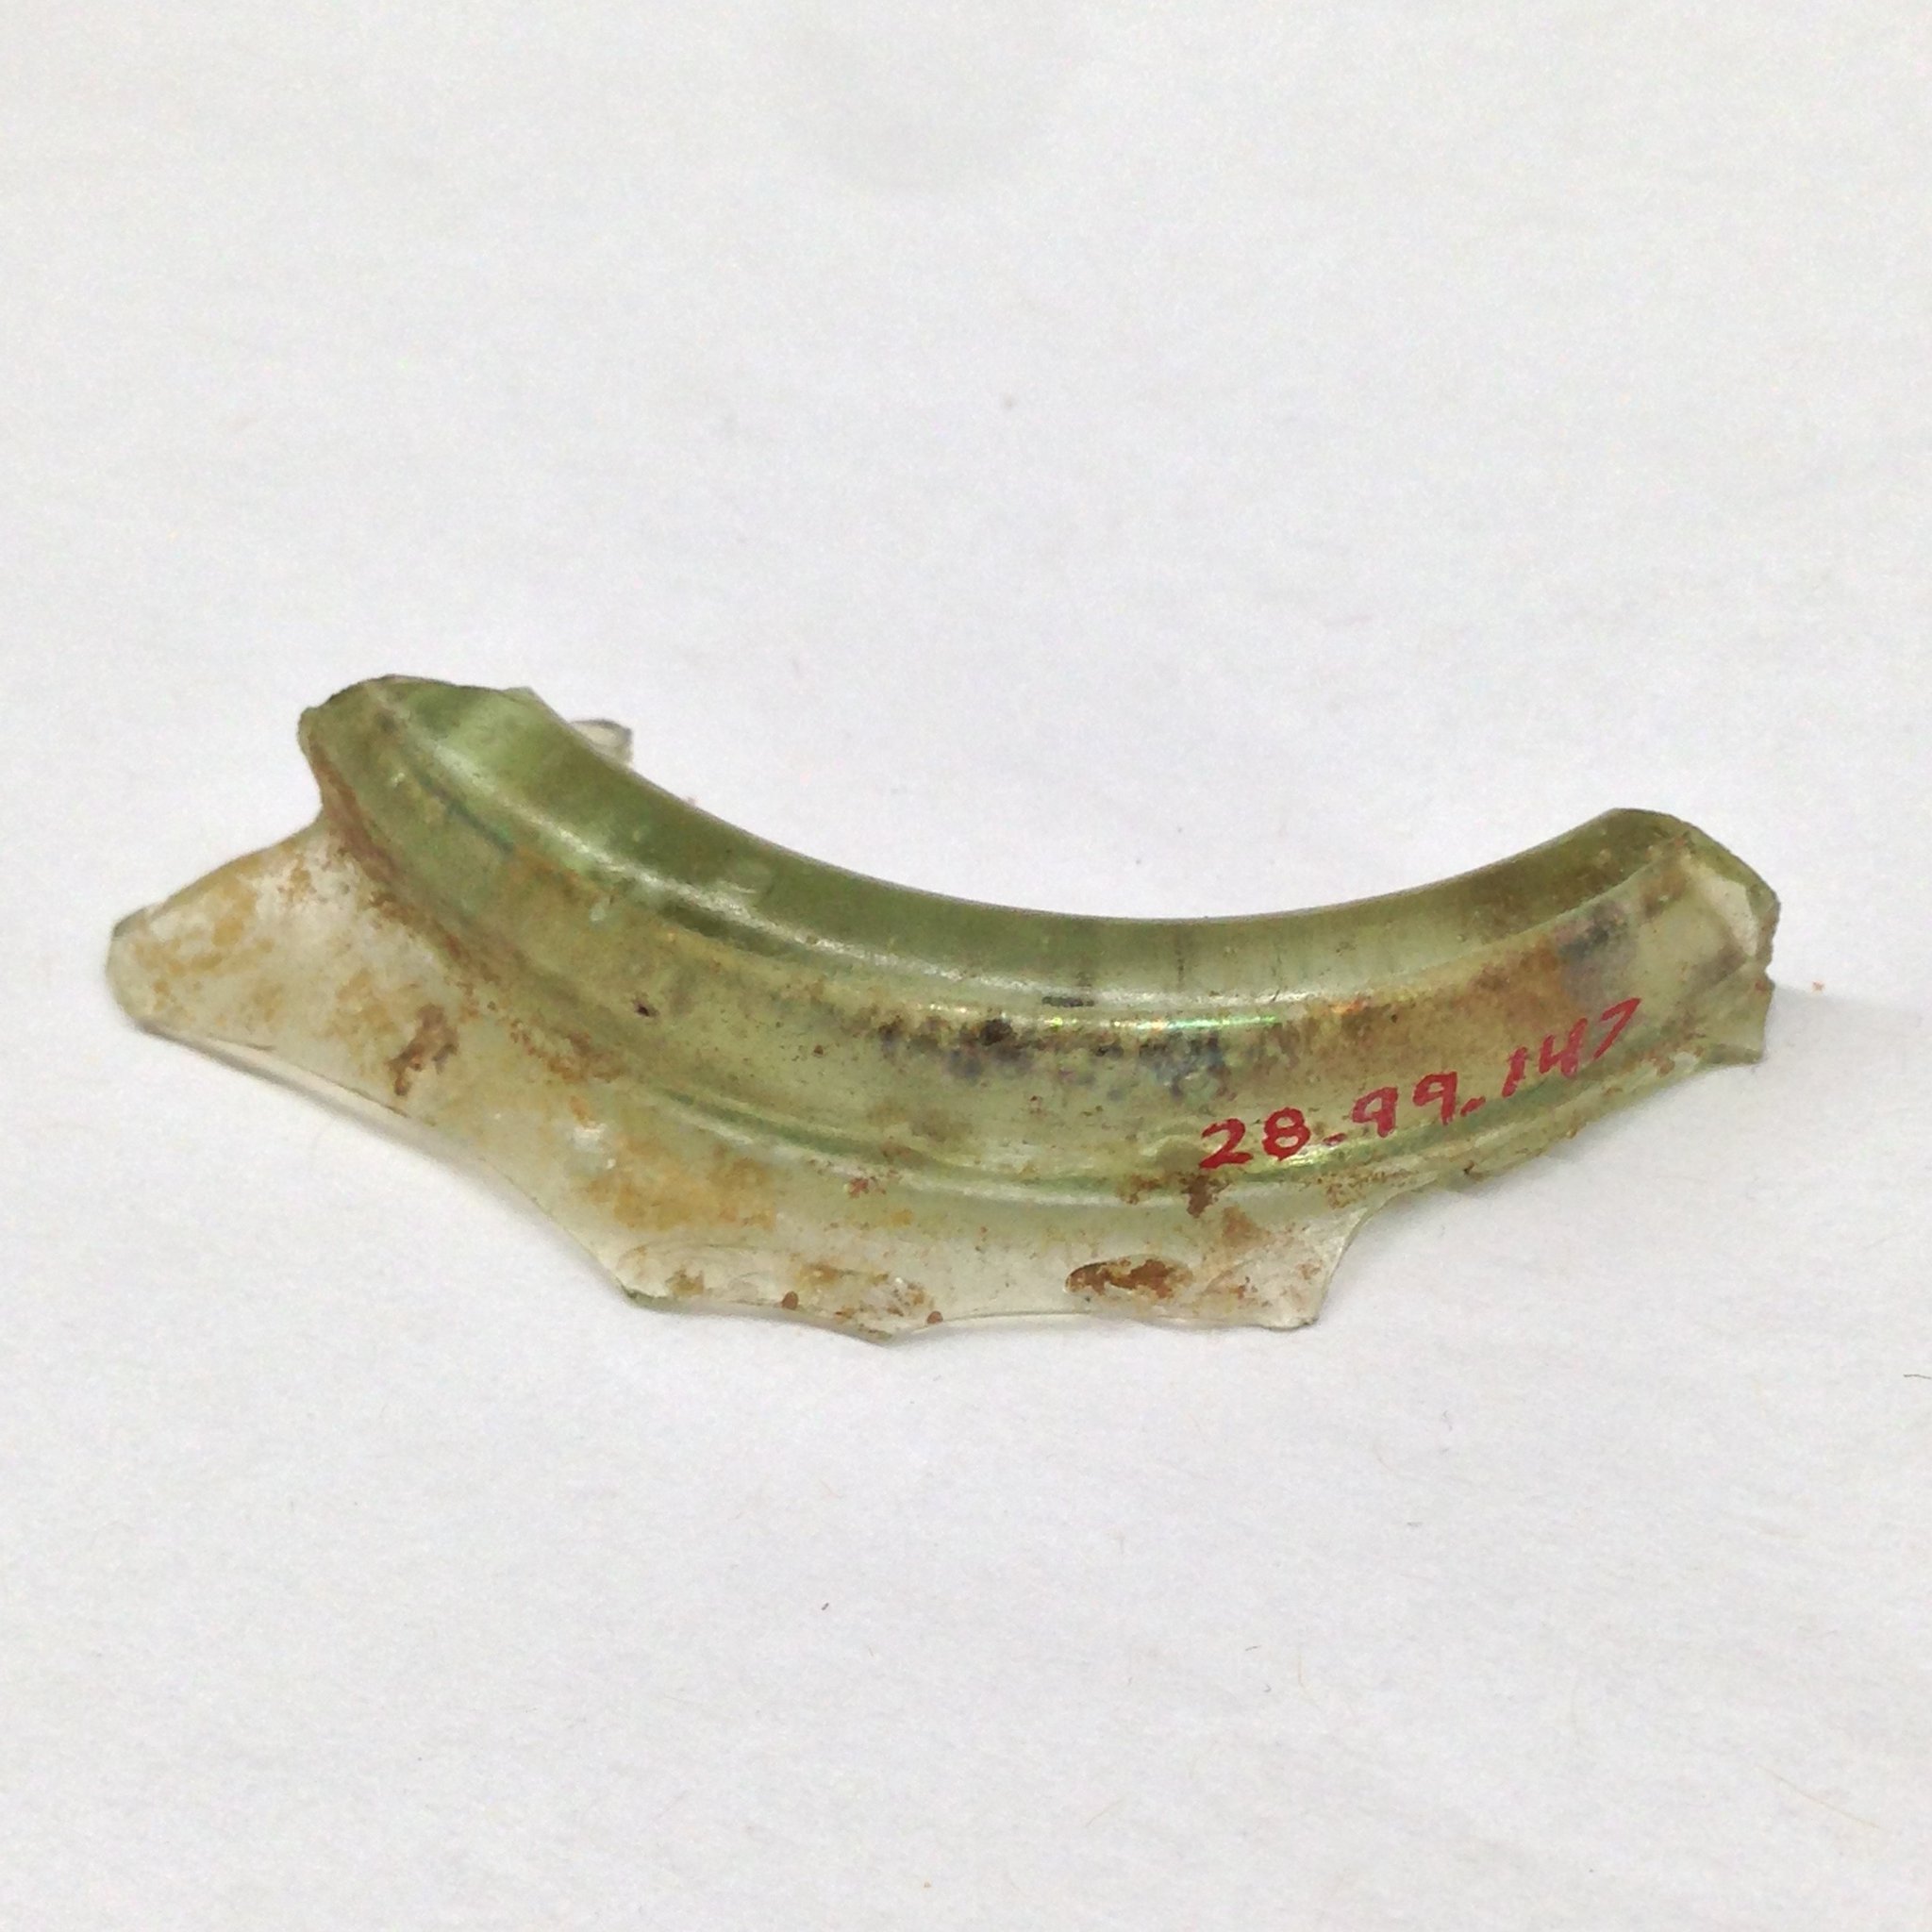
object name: fragment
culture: european or middle eastern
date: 1150-1250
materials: ceramic, glass